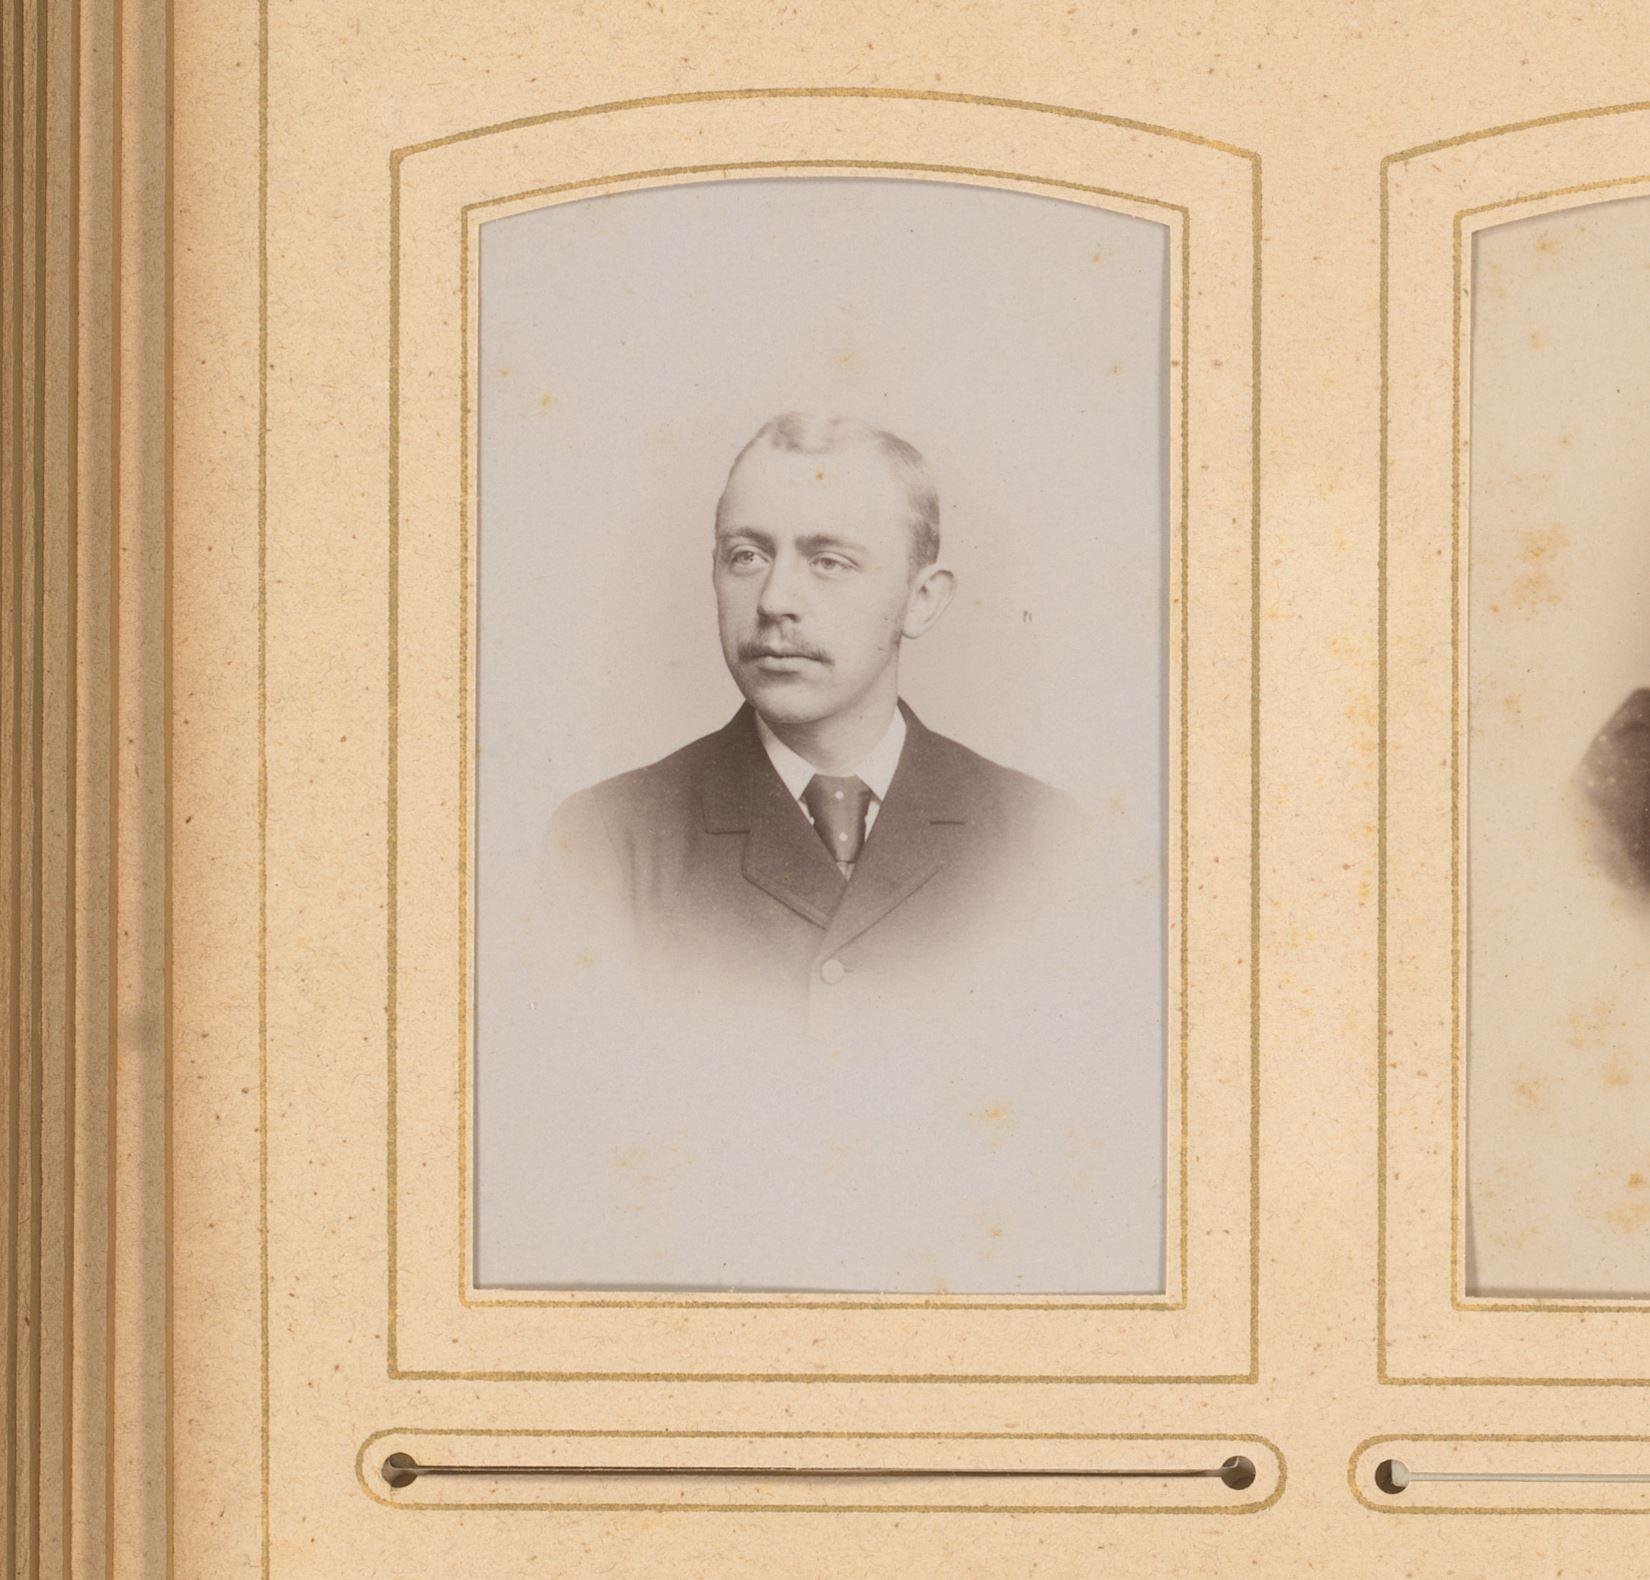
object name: album leaf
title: Portret van een man met snor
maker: johannes laurens theodorus huijsen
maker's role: fotograaf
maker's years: 1852-1910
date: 1883-1900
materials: cardboard, photographic support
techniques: albumen print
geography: hoorn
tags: moustache, historical persons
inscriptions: inscription: ‘J.L.T. HUIJSEN/ Photographe/ Bekroond op verschillende/ Tentoonstellingen/ HOORN/ Nieuwstraat.’